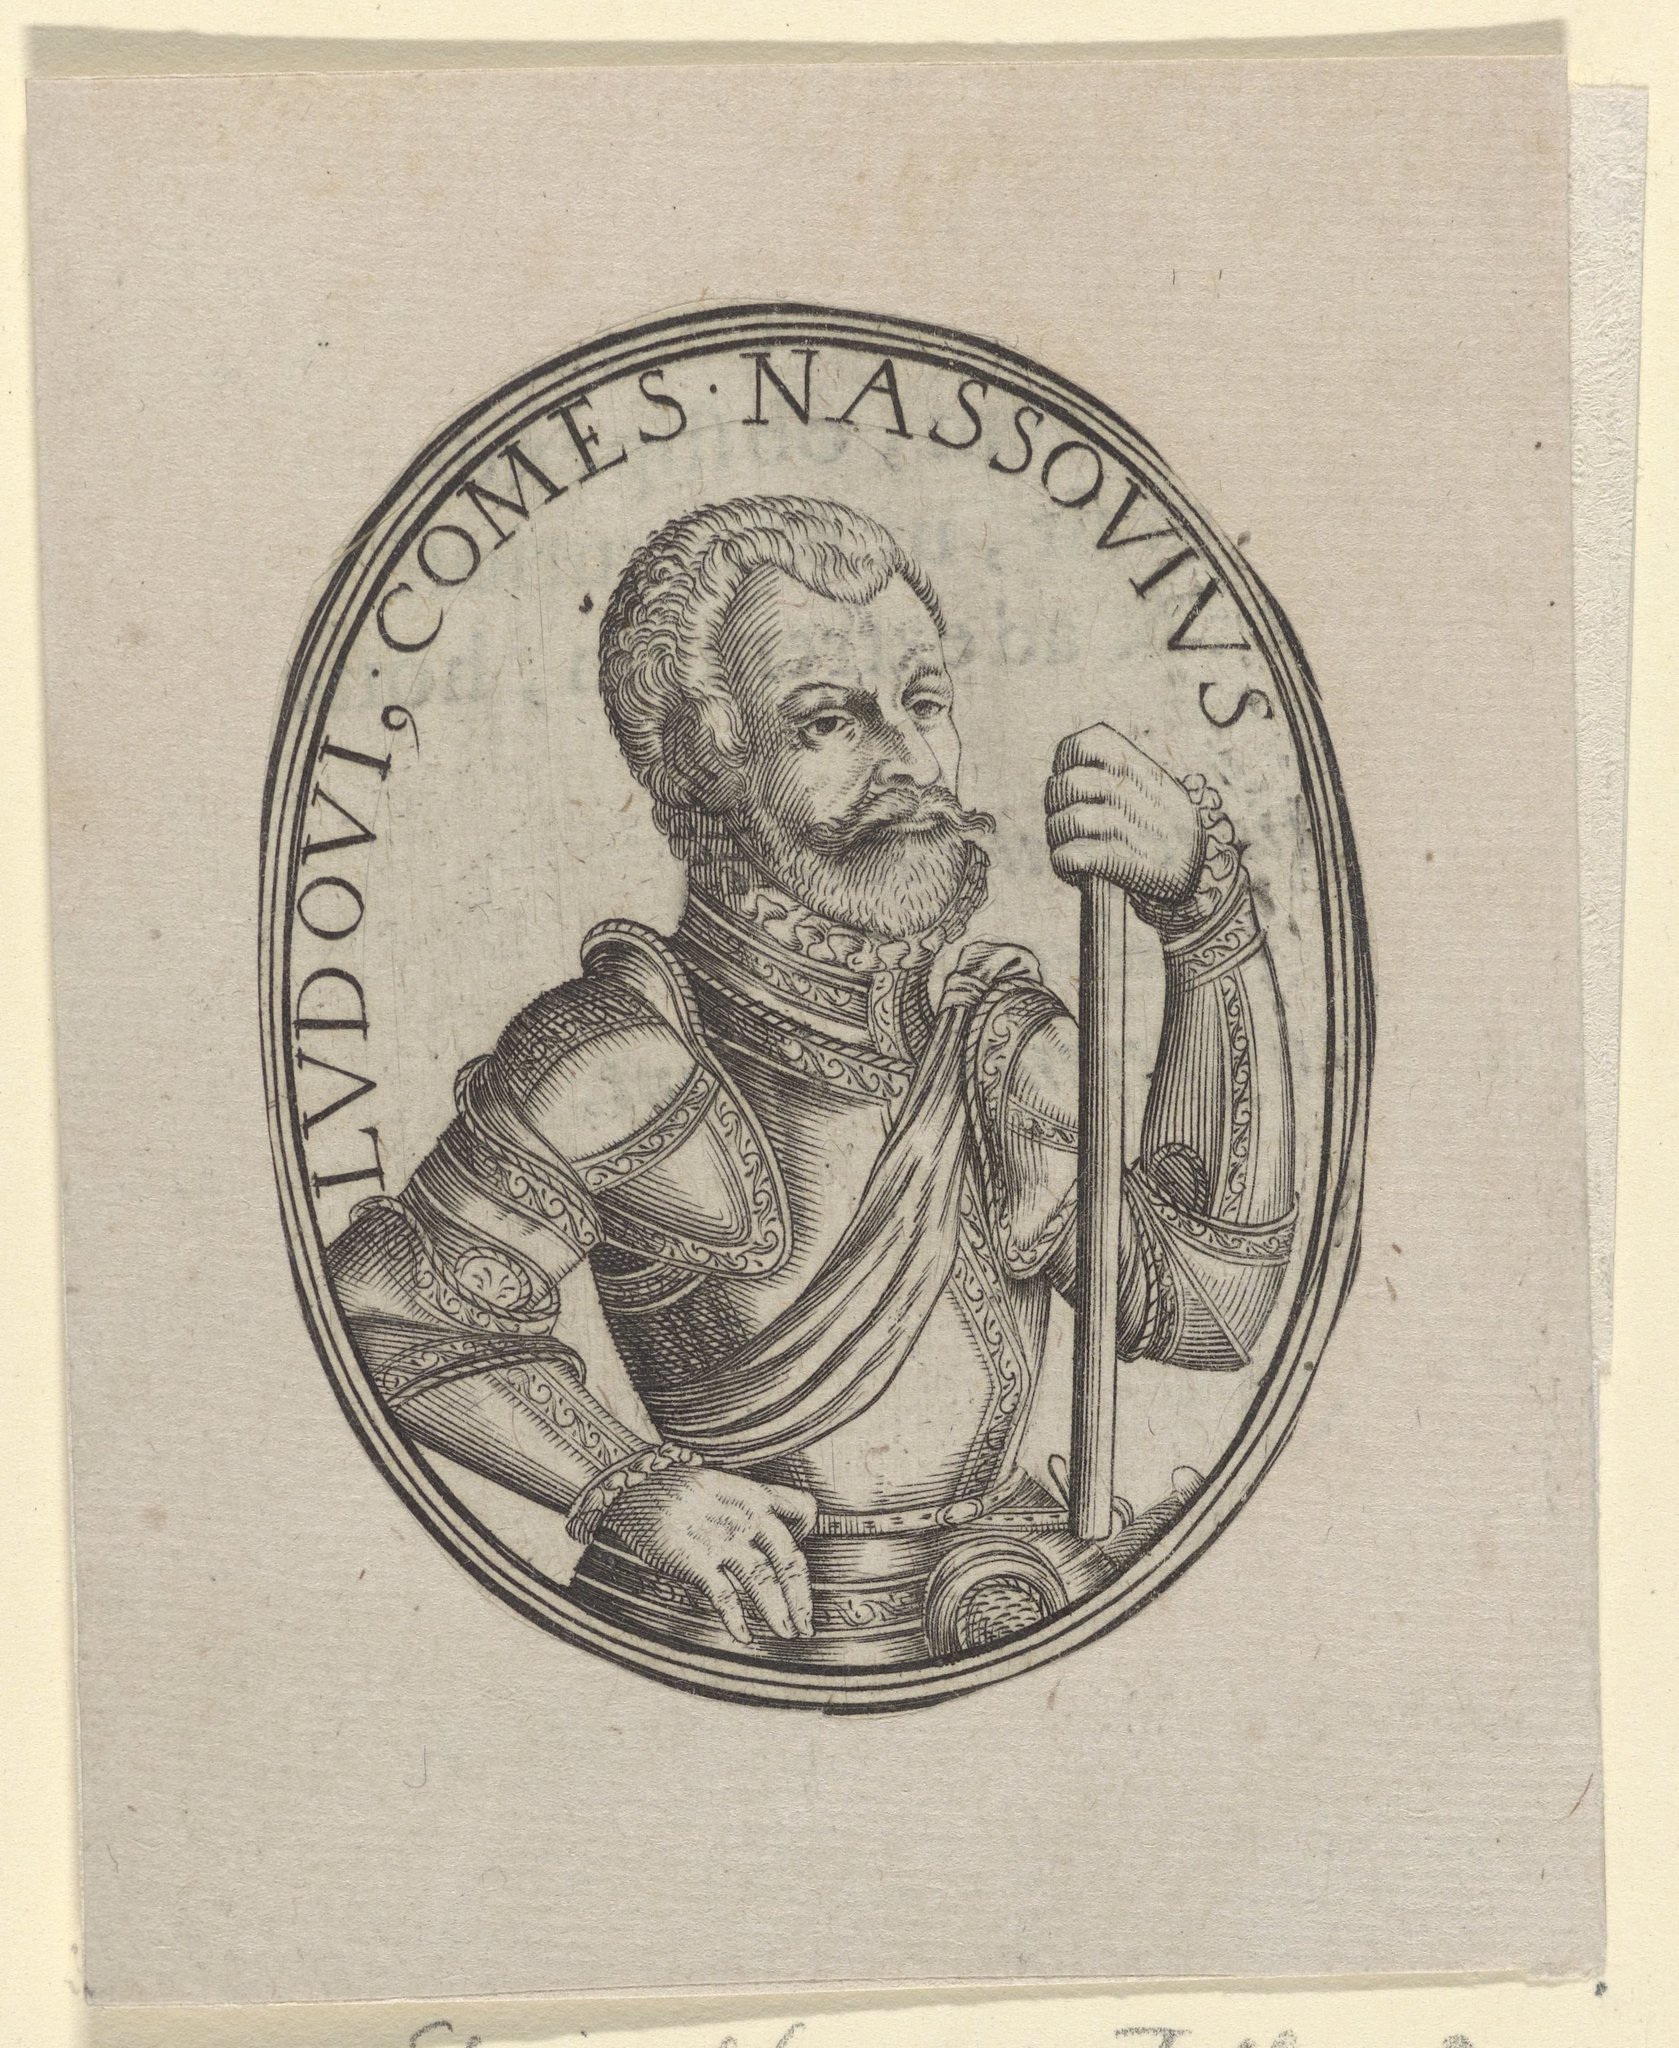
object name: print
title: Portret van Lodewijk, graaf van Nassau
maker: Anonymous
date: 1600-1699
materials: paper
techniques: engraving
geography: low countries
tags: lodewijk graaf van nassau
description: De hier vermelde titel verwijst naar de hoogst verkregen titel van de geportretteerde, niet per se naar de titel die de geportretteerde op deze voorstelling draagt.